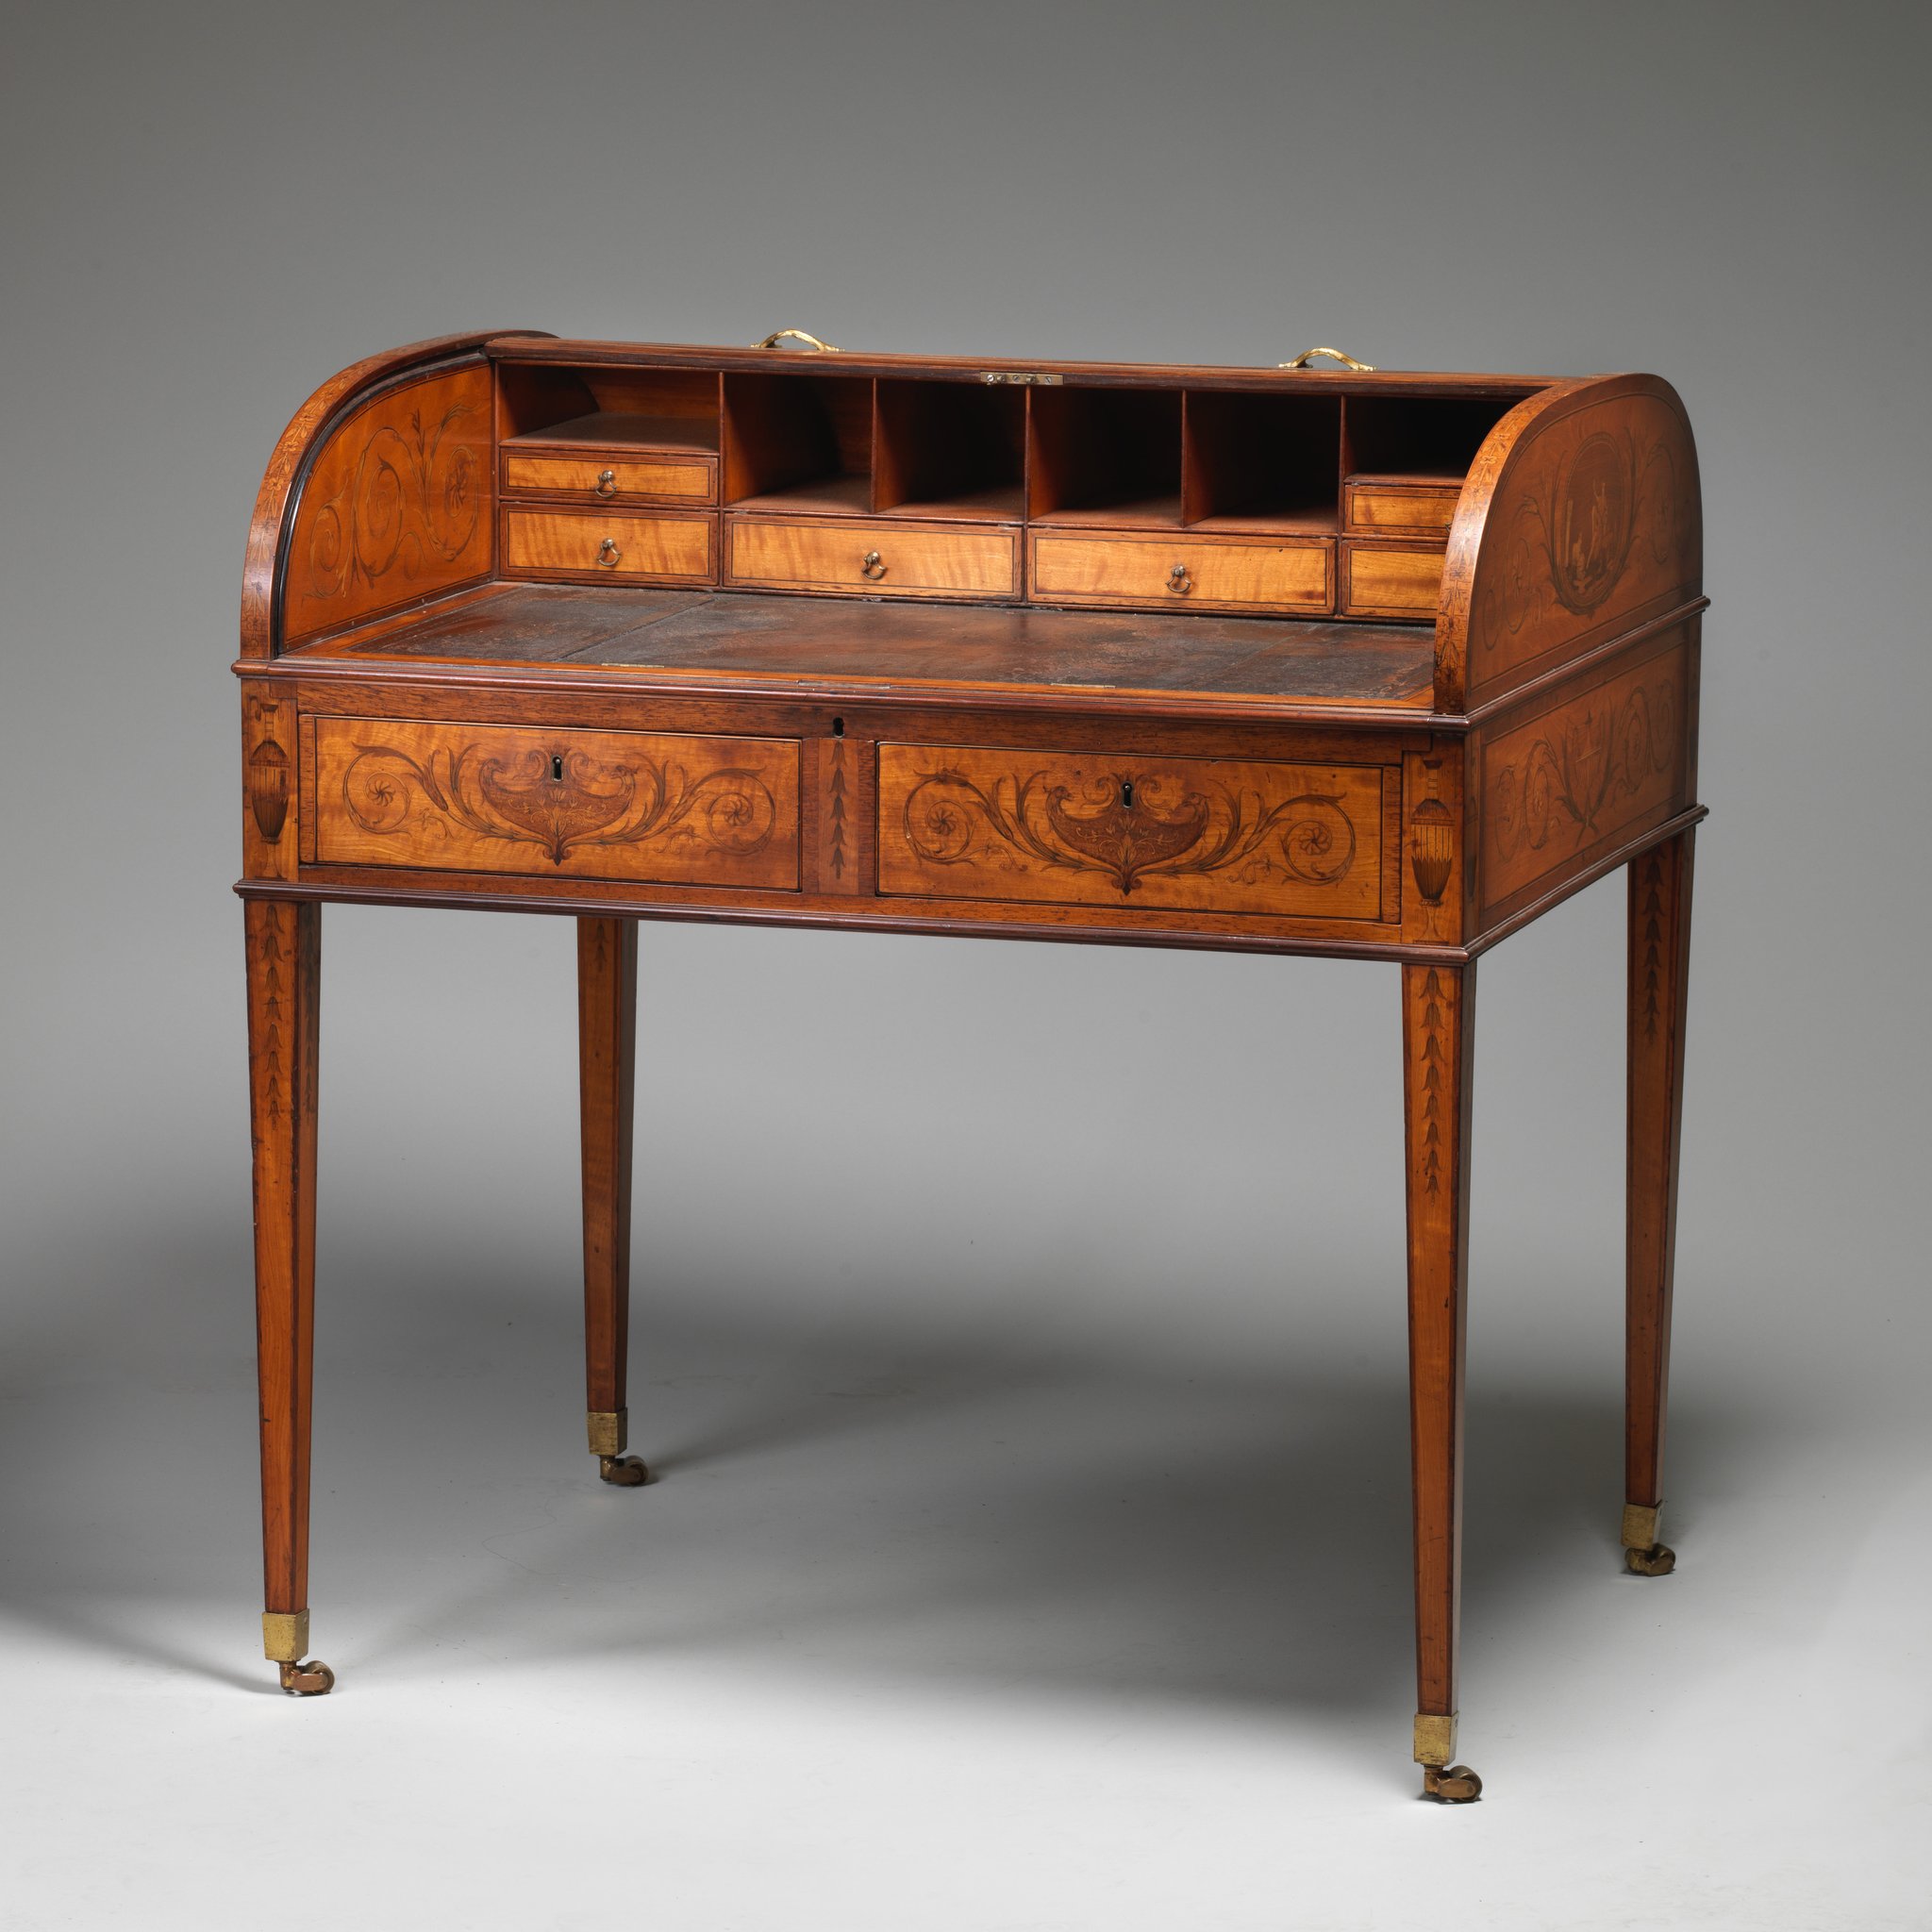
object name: desk or writing table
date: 1780-1790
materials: wood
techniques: inlay